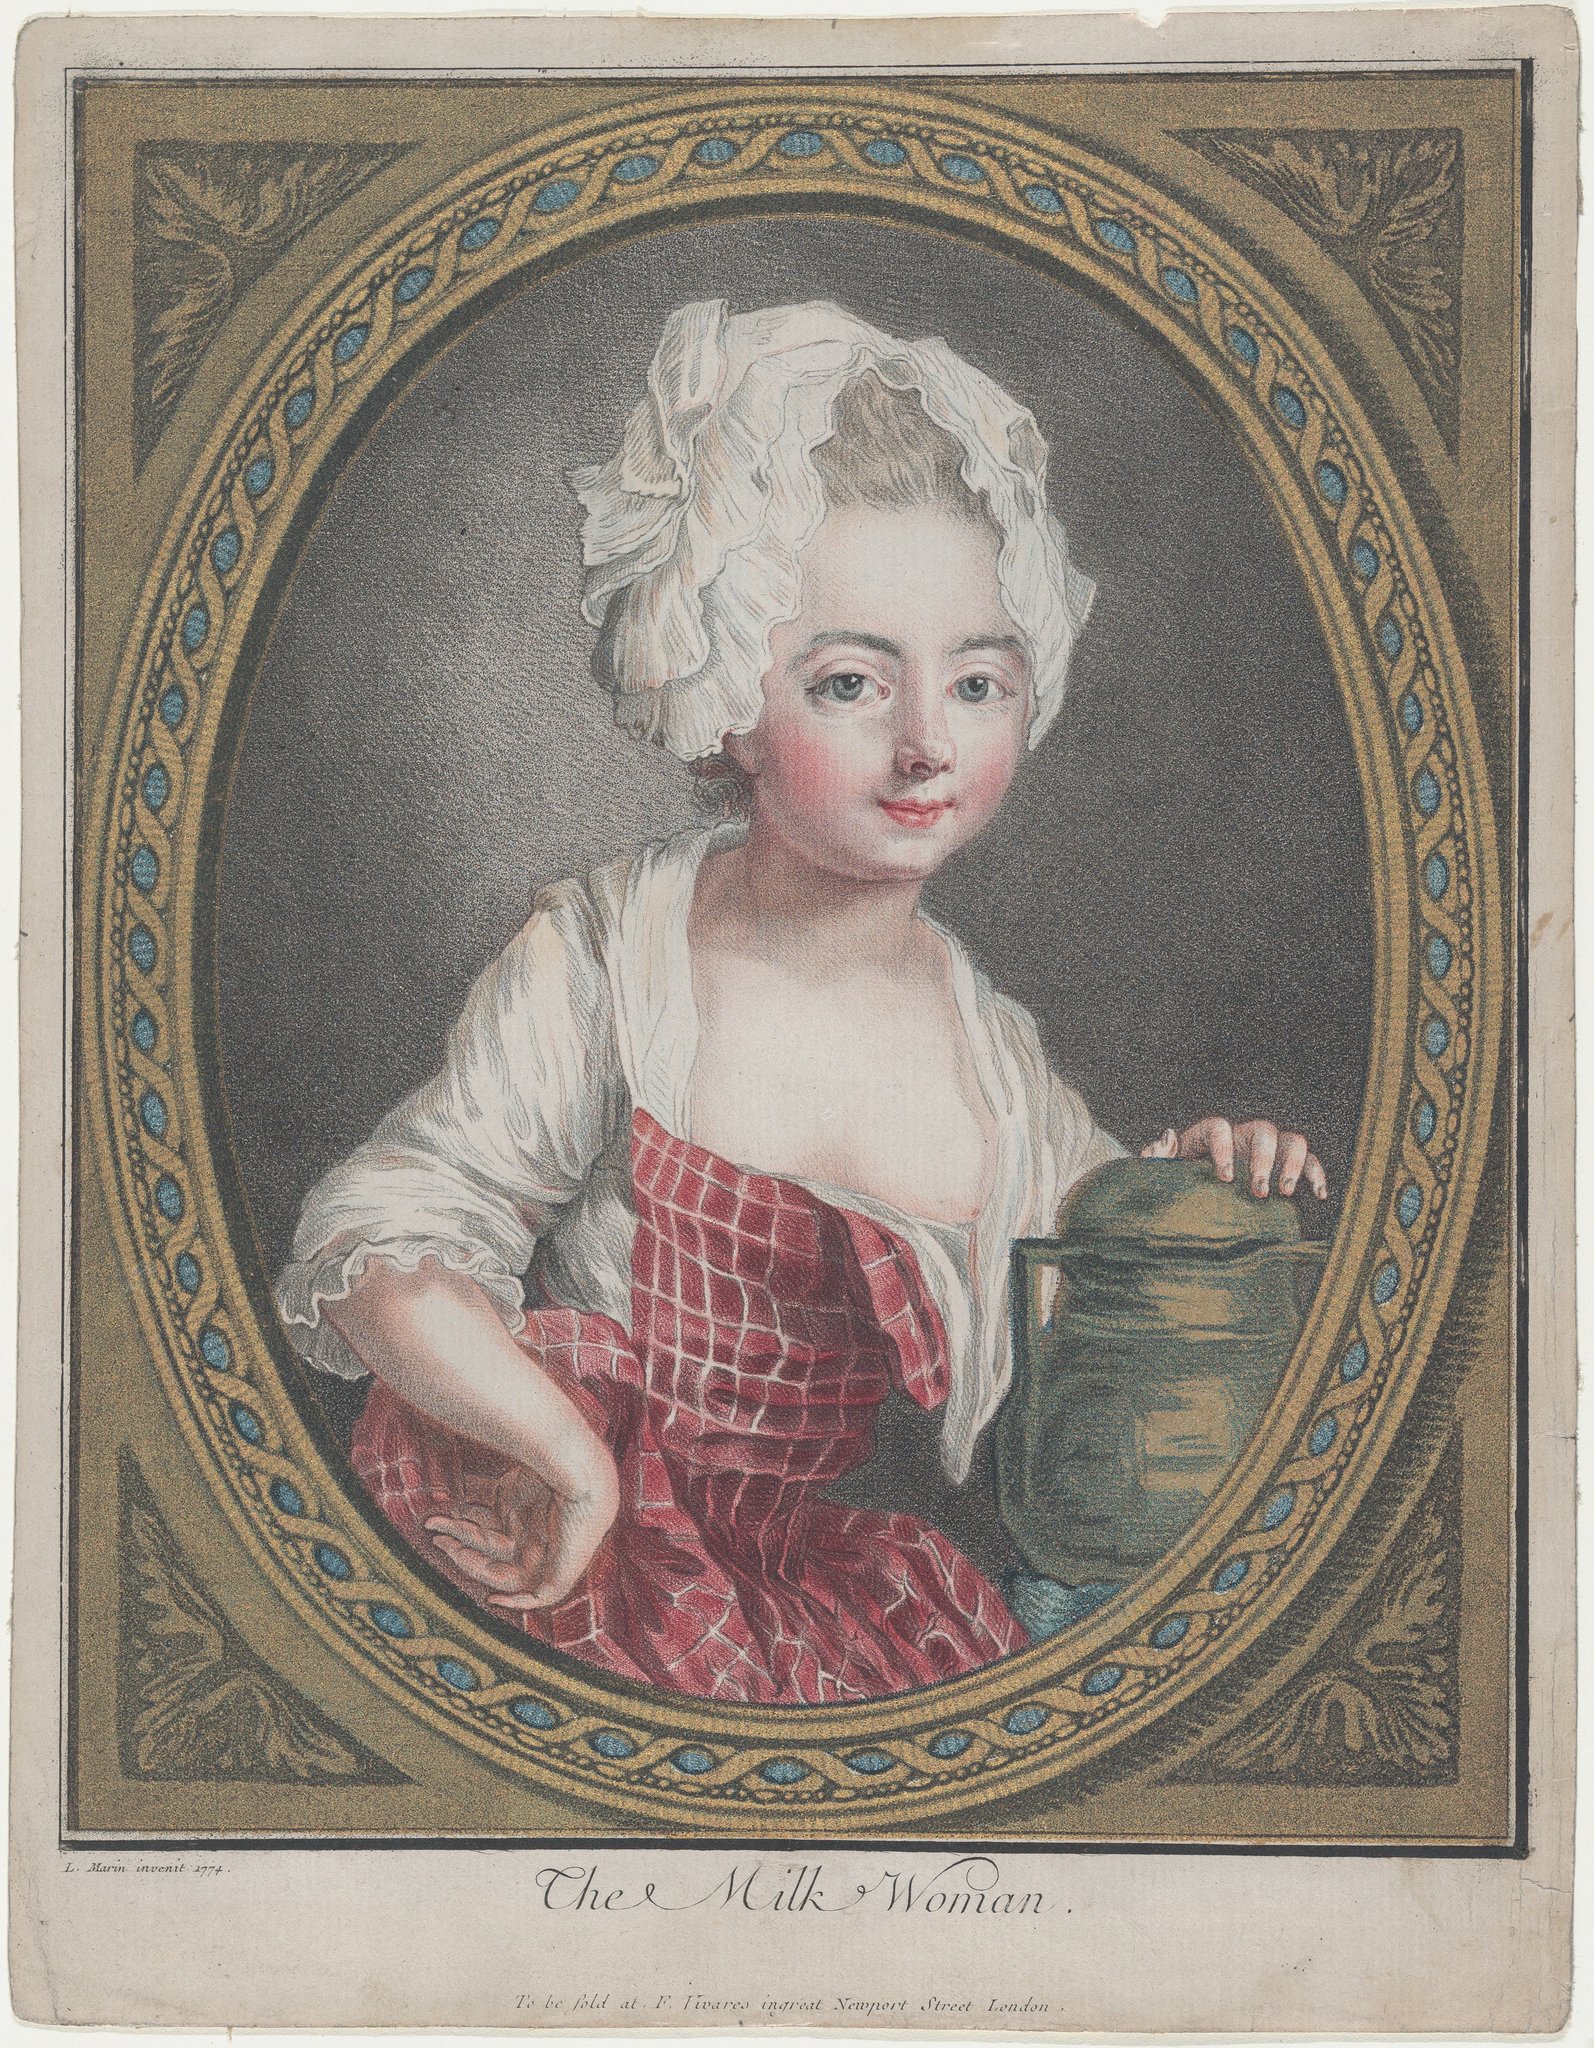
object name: print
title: The Milk Woman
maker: louis marin bonnet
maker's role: artist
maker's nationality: french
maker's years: 1736-1793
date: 1774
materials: gold leaf, ink, pastel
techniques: printing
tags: portraits,women